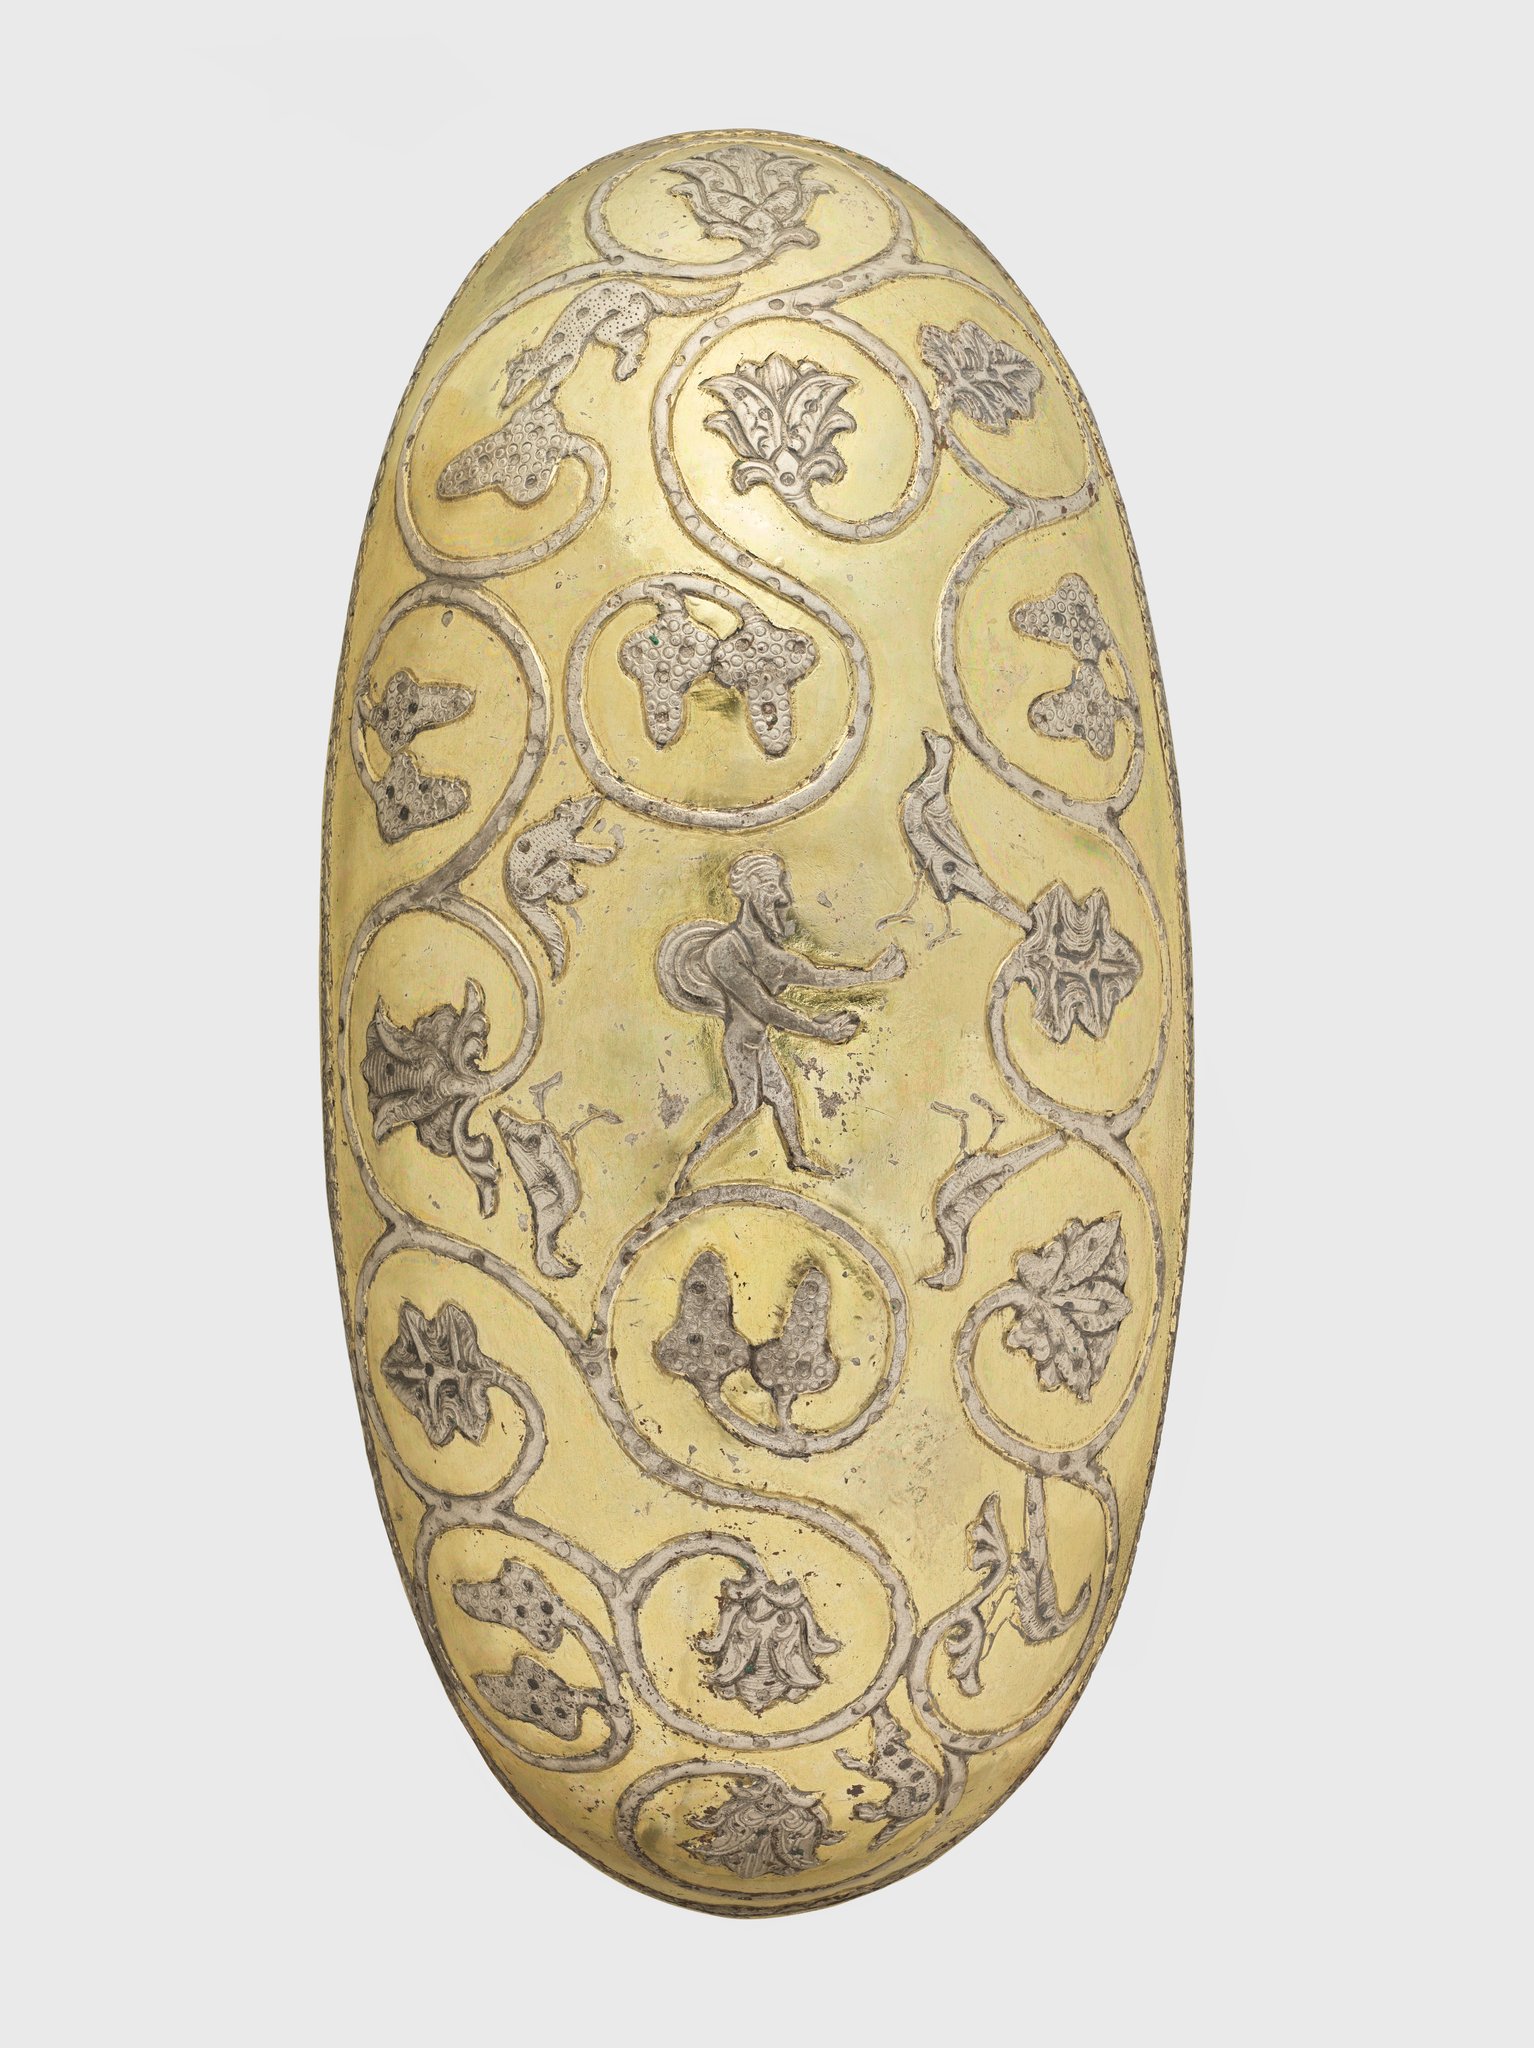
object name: bowl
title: Oval bowl with grapevine scrolls inhabited by birds and animals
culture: sasanian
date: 501-700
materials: mercury, silver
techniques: gilding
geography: iran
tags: animals,birds,grapes,men